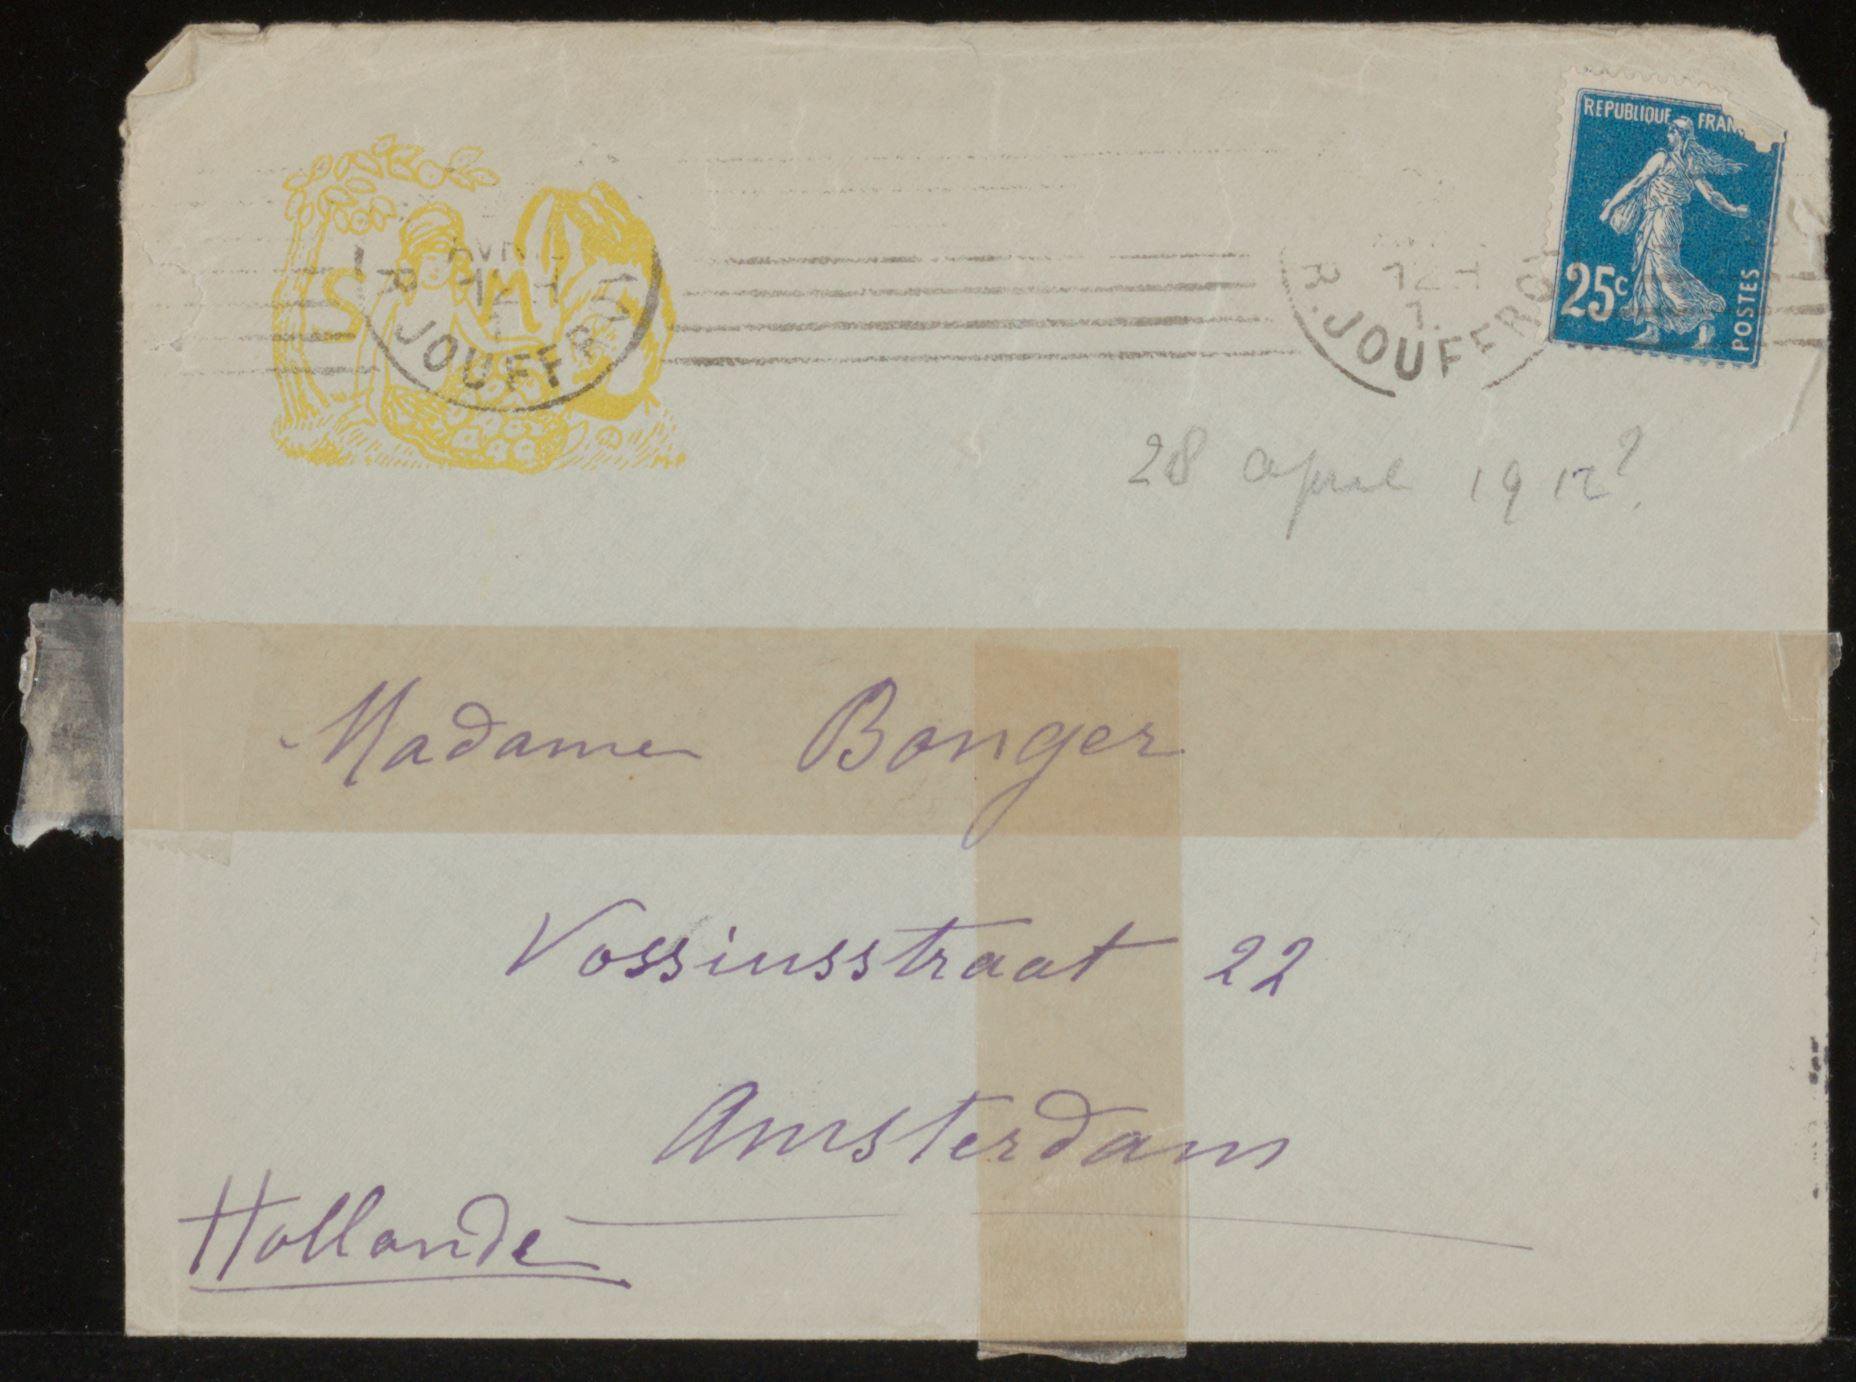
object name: envelope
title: Envelop aan Anne Marie Louise van der Linden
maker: camille redon-falte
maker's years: 1853-1923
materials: ink, paper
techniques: pen, writing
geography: paris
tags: anne marie louise van der linden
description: Envelop behoort tot een album samengesteld door weduwe Françoise W.M. Barones van der Borch van Verwolde met afschriften van brieven met betrekking tot (de familie van) Odilon Redon. De envelop werd bewaard op pagina 186.